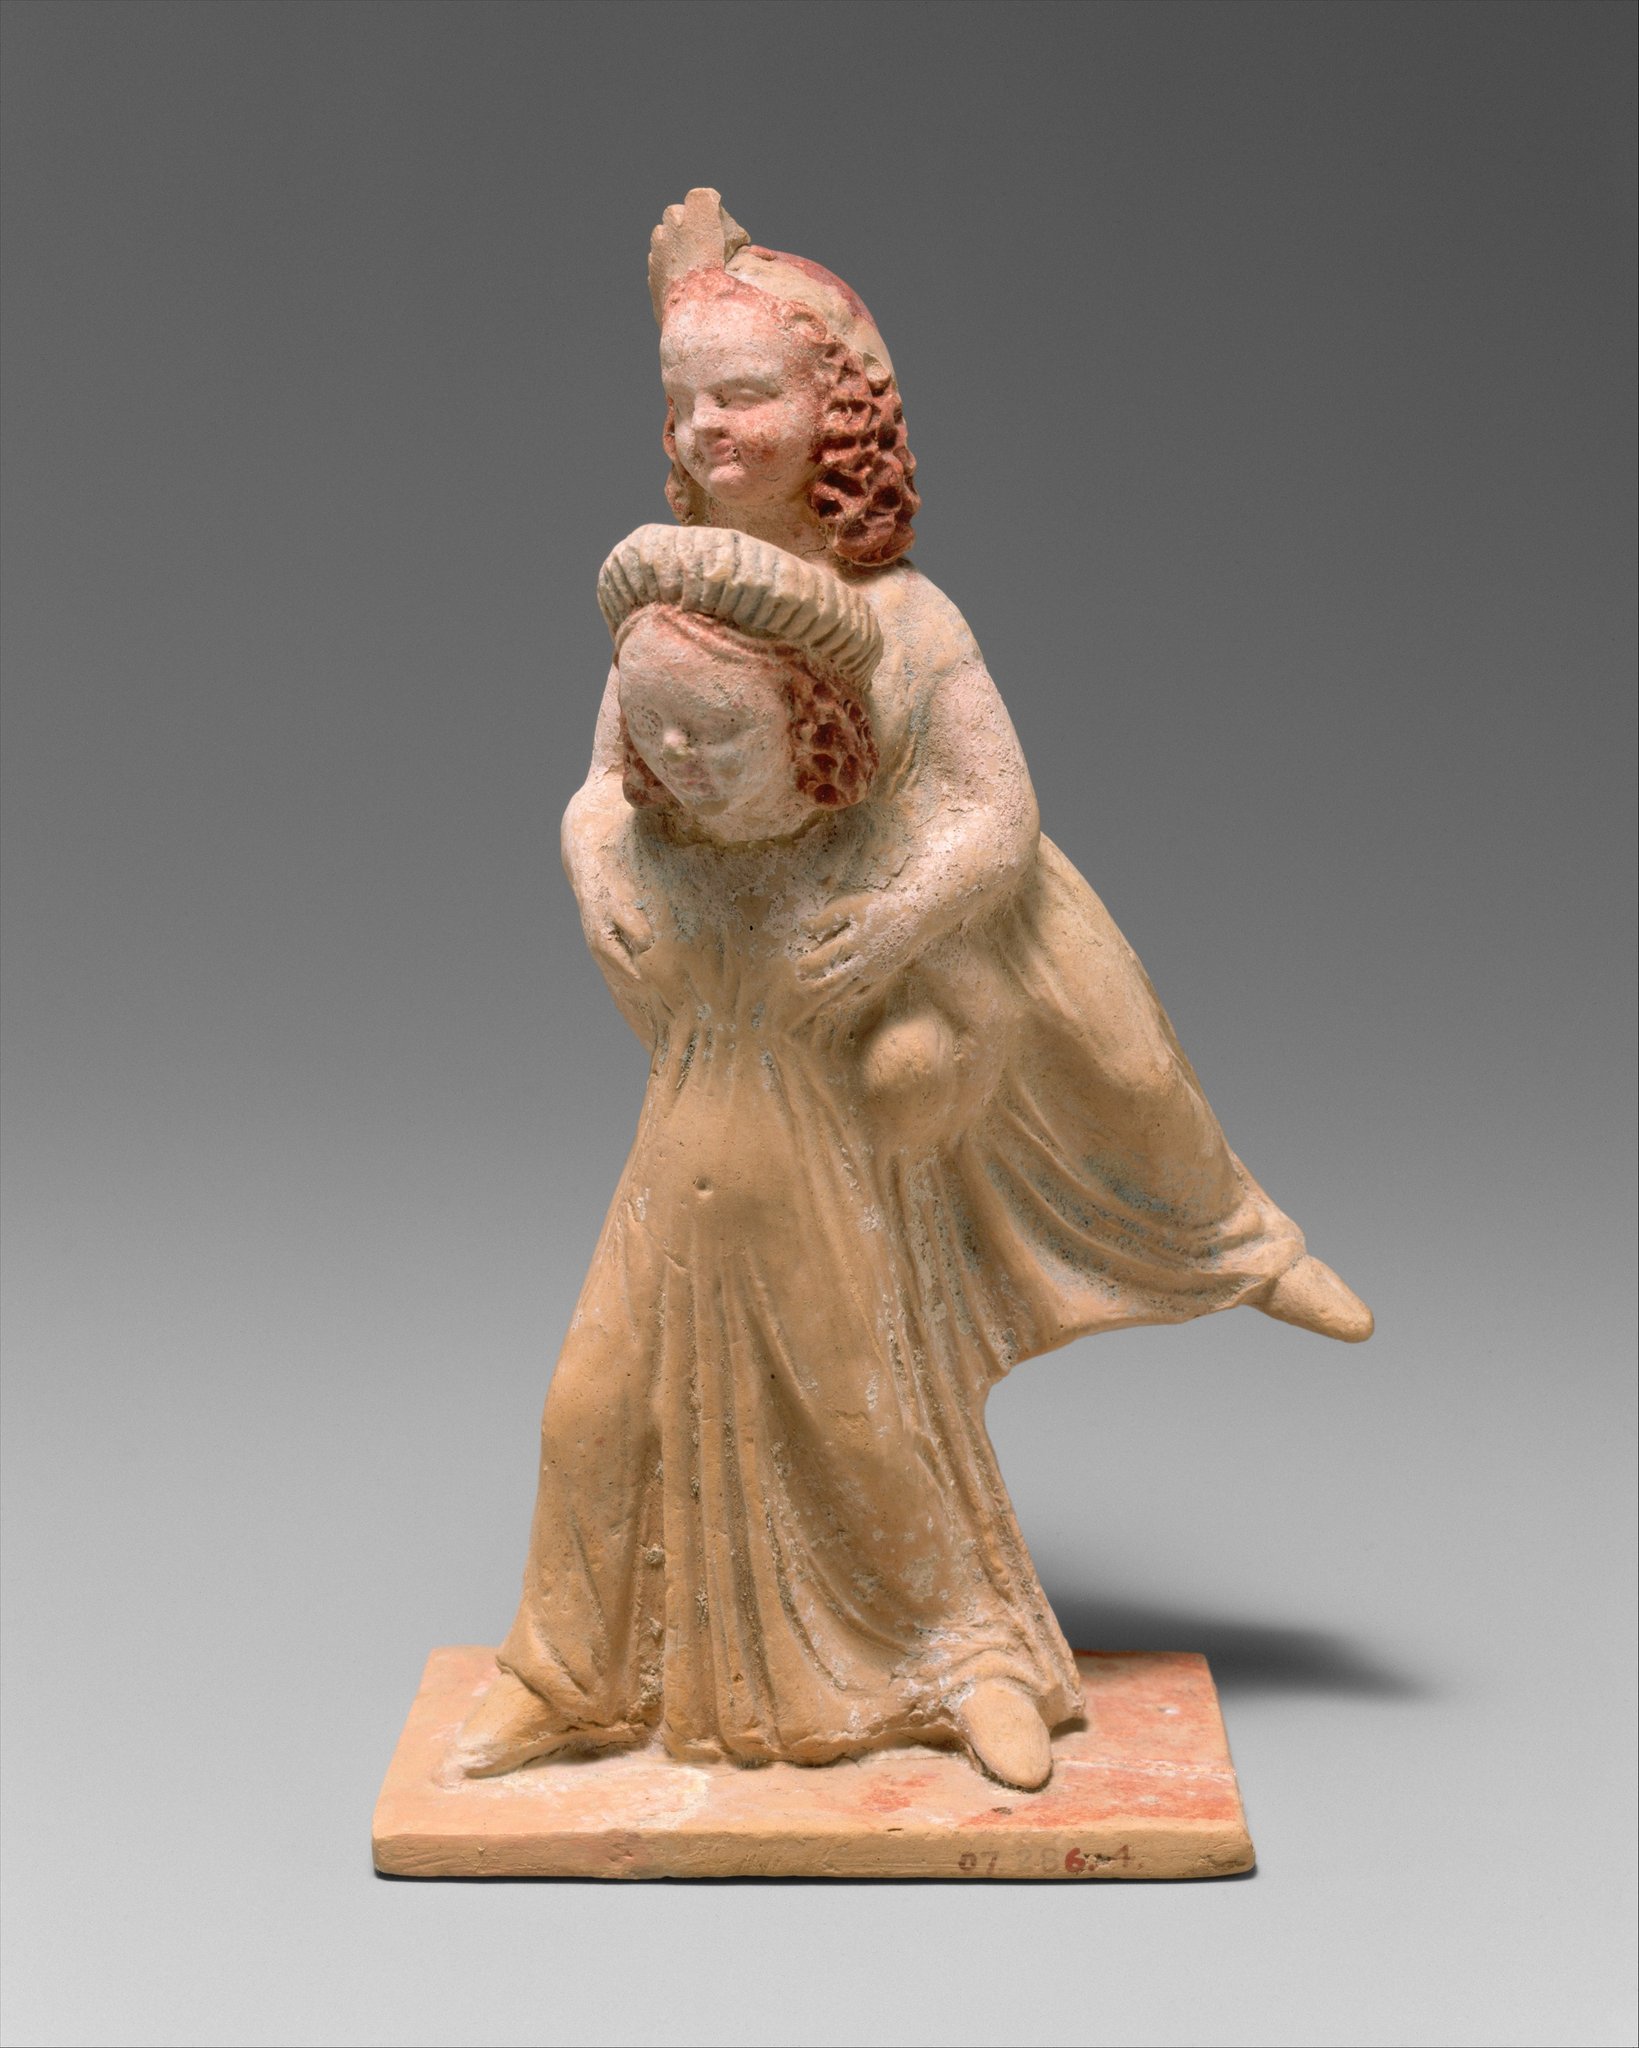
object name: ephedrismos group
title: Terracotta group of two girls playing a game known as ephedrismos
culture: greek, corinthian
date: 334-268 BCE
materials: terracotta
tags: girls,playing